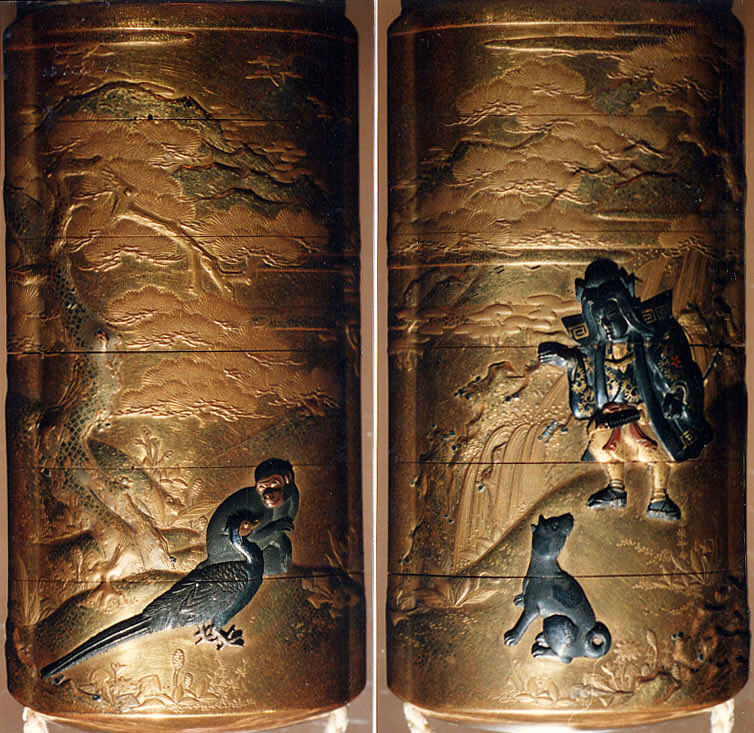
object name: inrō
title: Case (Inrō) with Design of Momotarō and Dog on the way to the Island of the Devils (obverse); Monkey with Pheasant (reverse)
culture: japanese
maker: kogyoku tokayo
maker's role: artist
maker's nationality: japanese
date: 1801-1900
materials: gold, lacquer, metal, silver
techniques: fundame, inlay, maki, polish, relief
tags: men,pheasants,dogs,monkeys